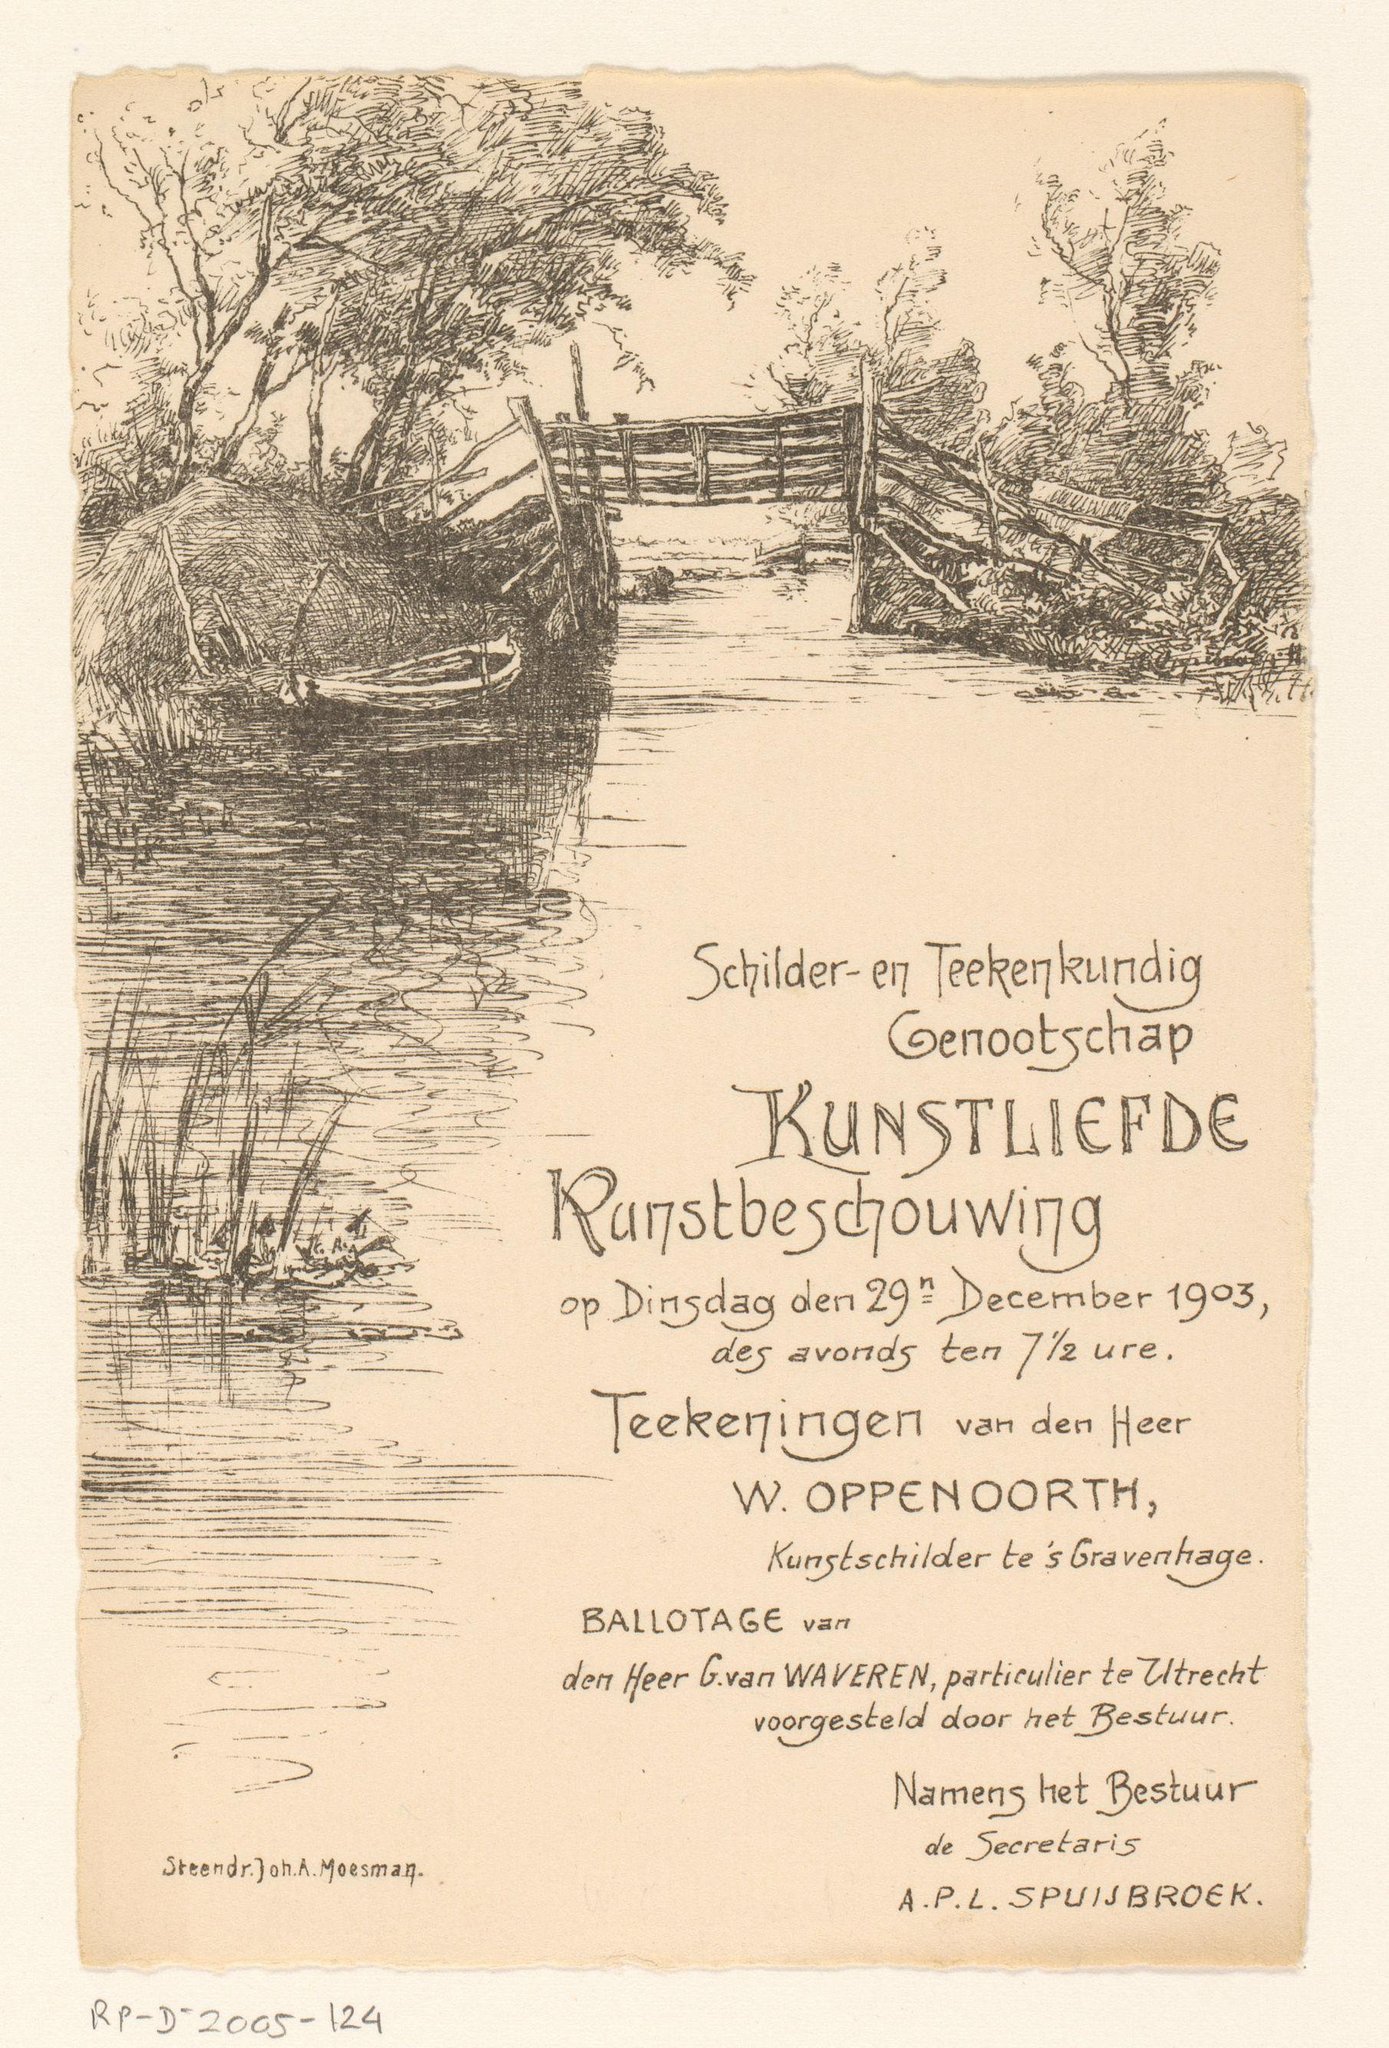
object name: print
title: Uitnodiging van Schilder- en Teekenkundig Genootschap "Kunstliefde" voor een kunstbeschouwing, 29 december 1903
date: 1903-1912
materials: paper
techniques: lithograph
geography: netherlands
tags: criticizing and discussing art, art criticism, circle, club of artists, collecting and exhibiting products of the fine arts, water course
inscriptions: collector's mark: Lugt 2228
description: Sloot met brug. Uitnodiging van Schilder- en Teekenkundig Genootschap "Kunstliefde" voor een kunstbeschouwing op 29 december 1903 van tekeningen van dhr. W. Oppenoorth, kunstschilder te Den Haag.